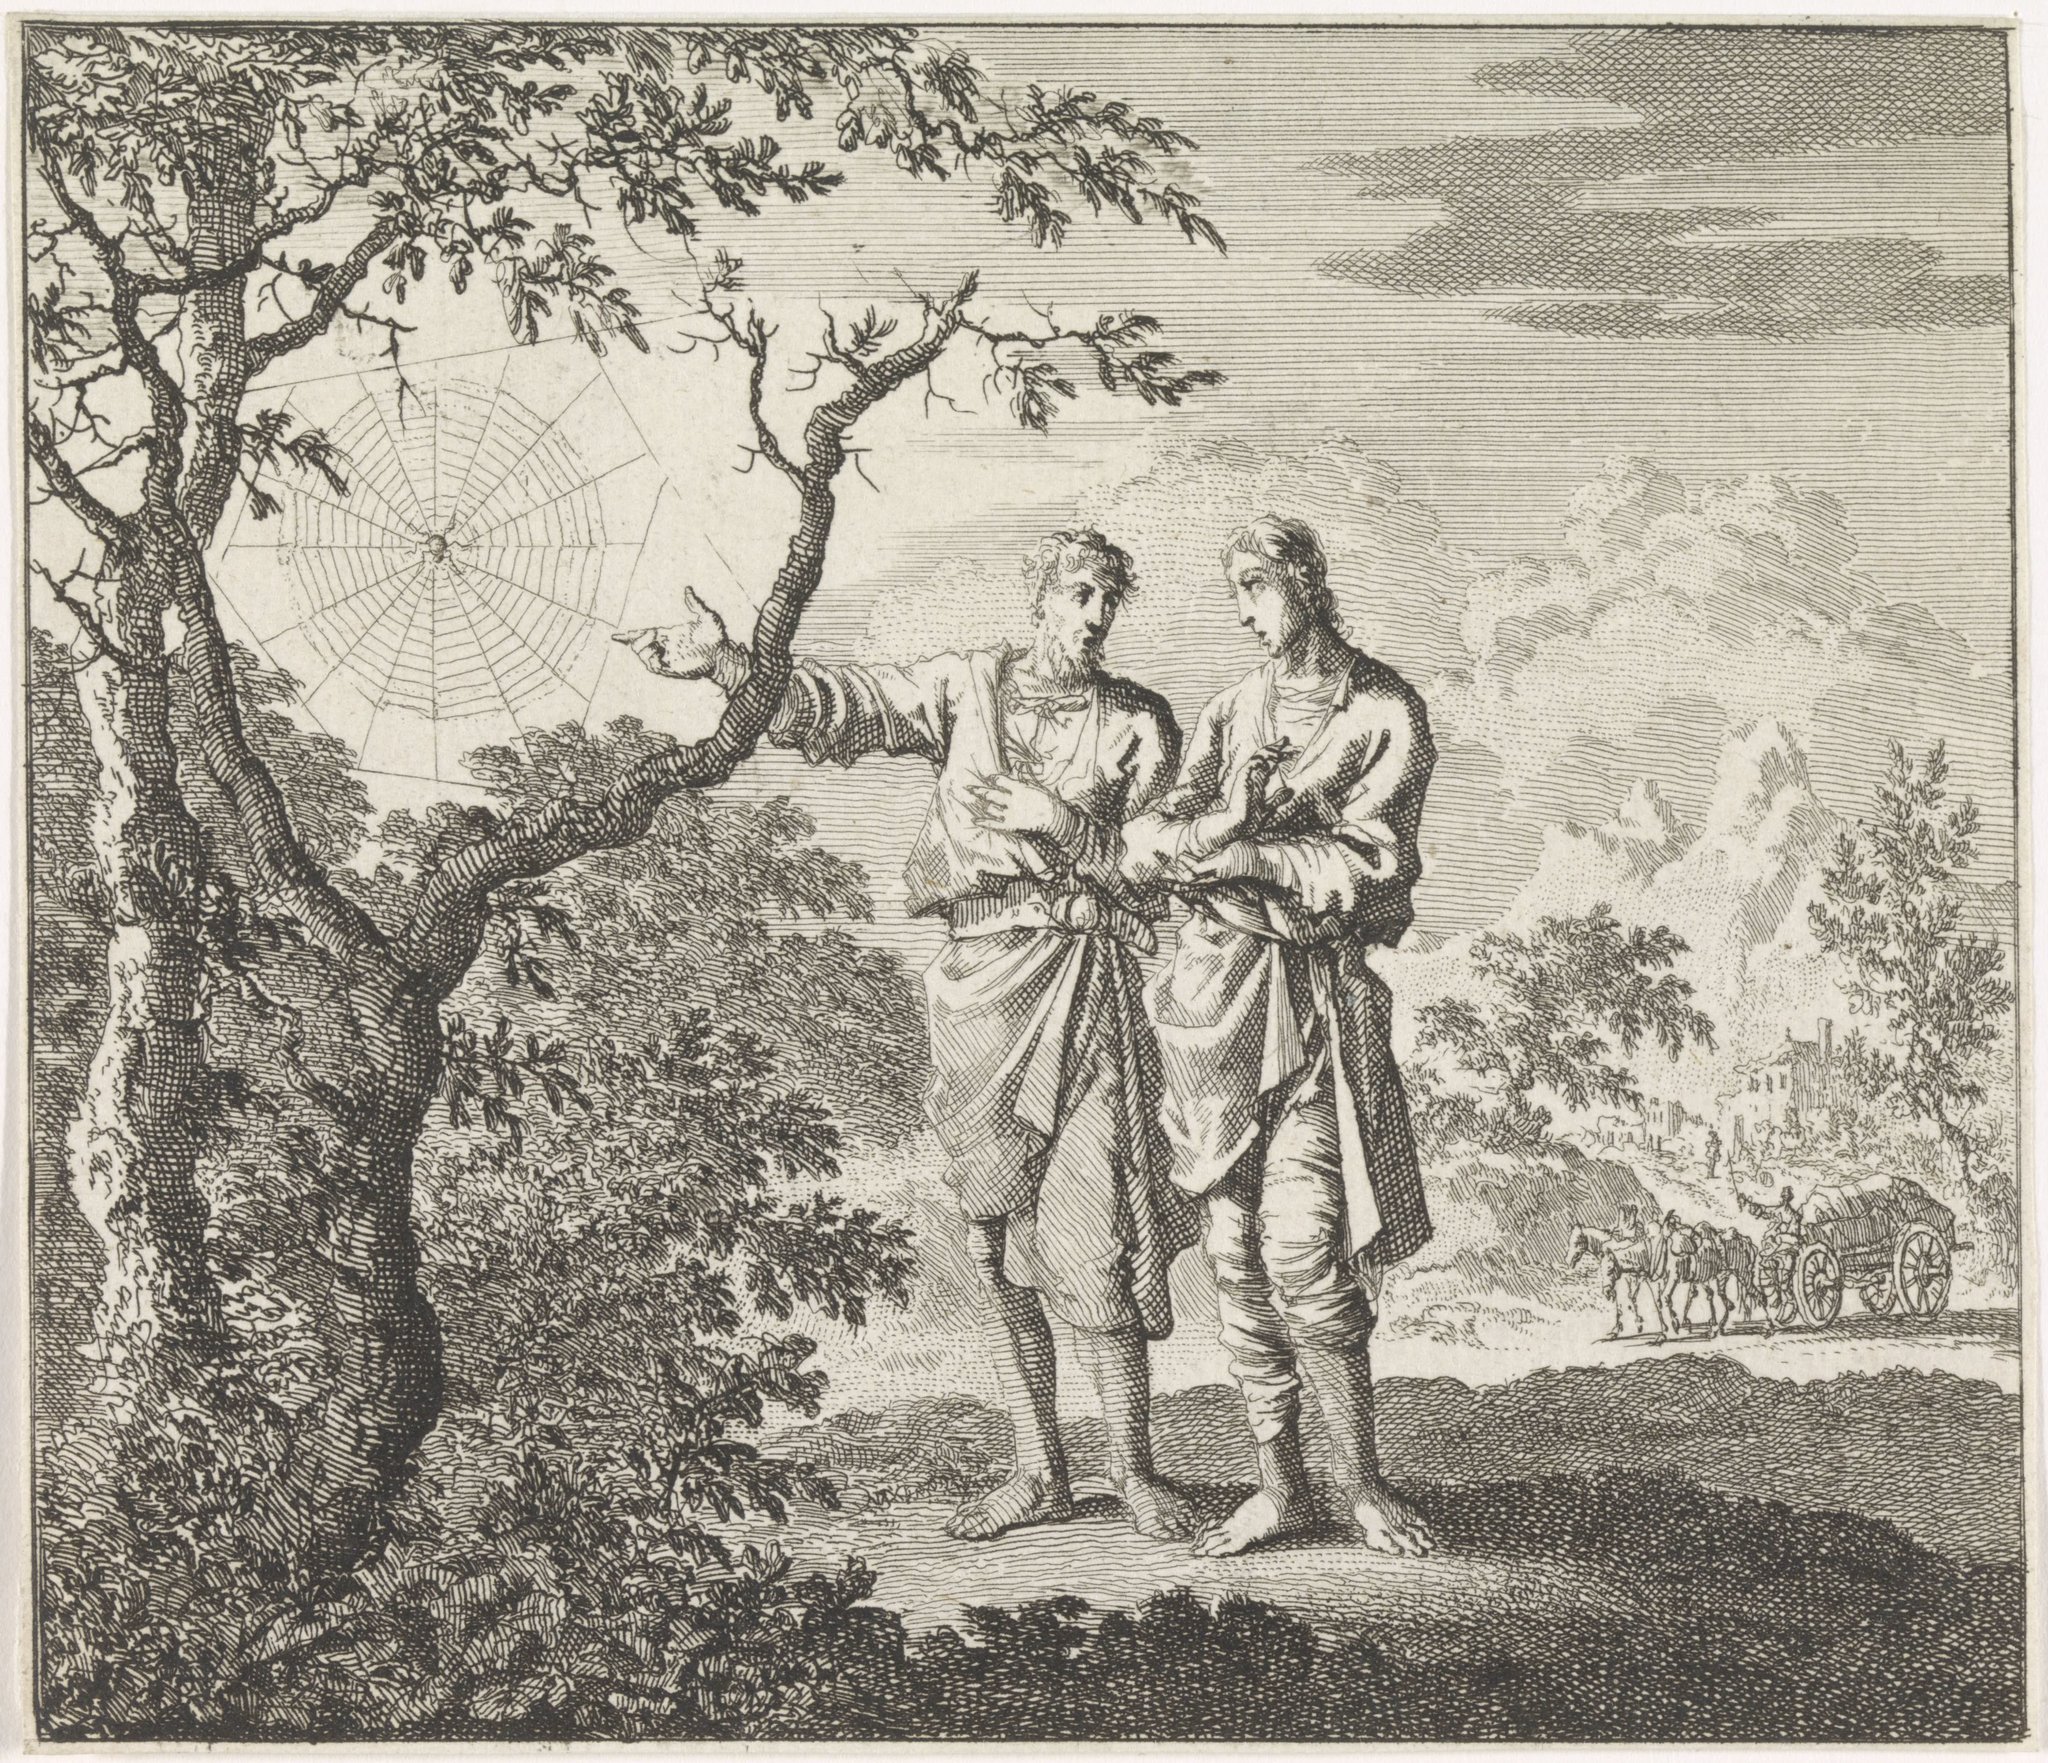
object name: print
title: Twee mannen bekijken een spinnenweb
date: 1695-1705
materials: paper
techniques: etching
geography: amsterdam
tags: trees, standing figure (+ male human being (not to be used where -a- is prescribed)), spiders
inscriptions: collector's mark: Lugt 240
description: Boekillustratie voor Weigel, Christoph. Ethica Naturalis seu Documenta Moralia e Variis rerum Naturalium proprietatibus Virtutum Vitiorumq symbolicis imaginibus collecta. Neurenberg: Christoph Weigel: c. 1700.